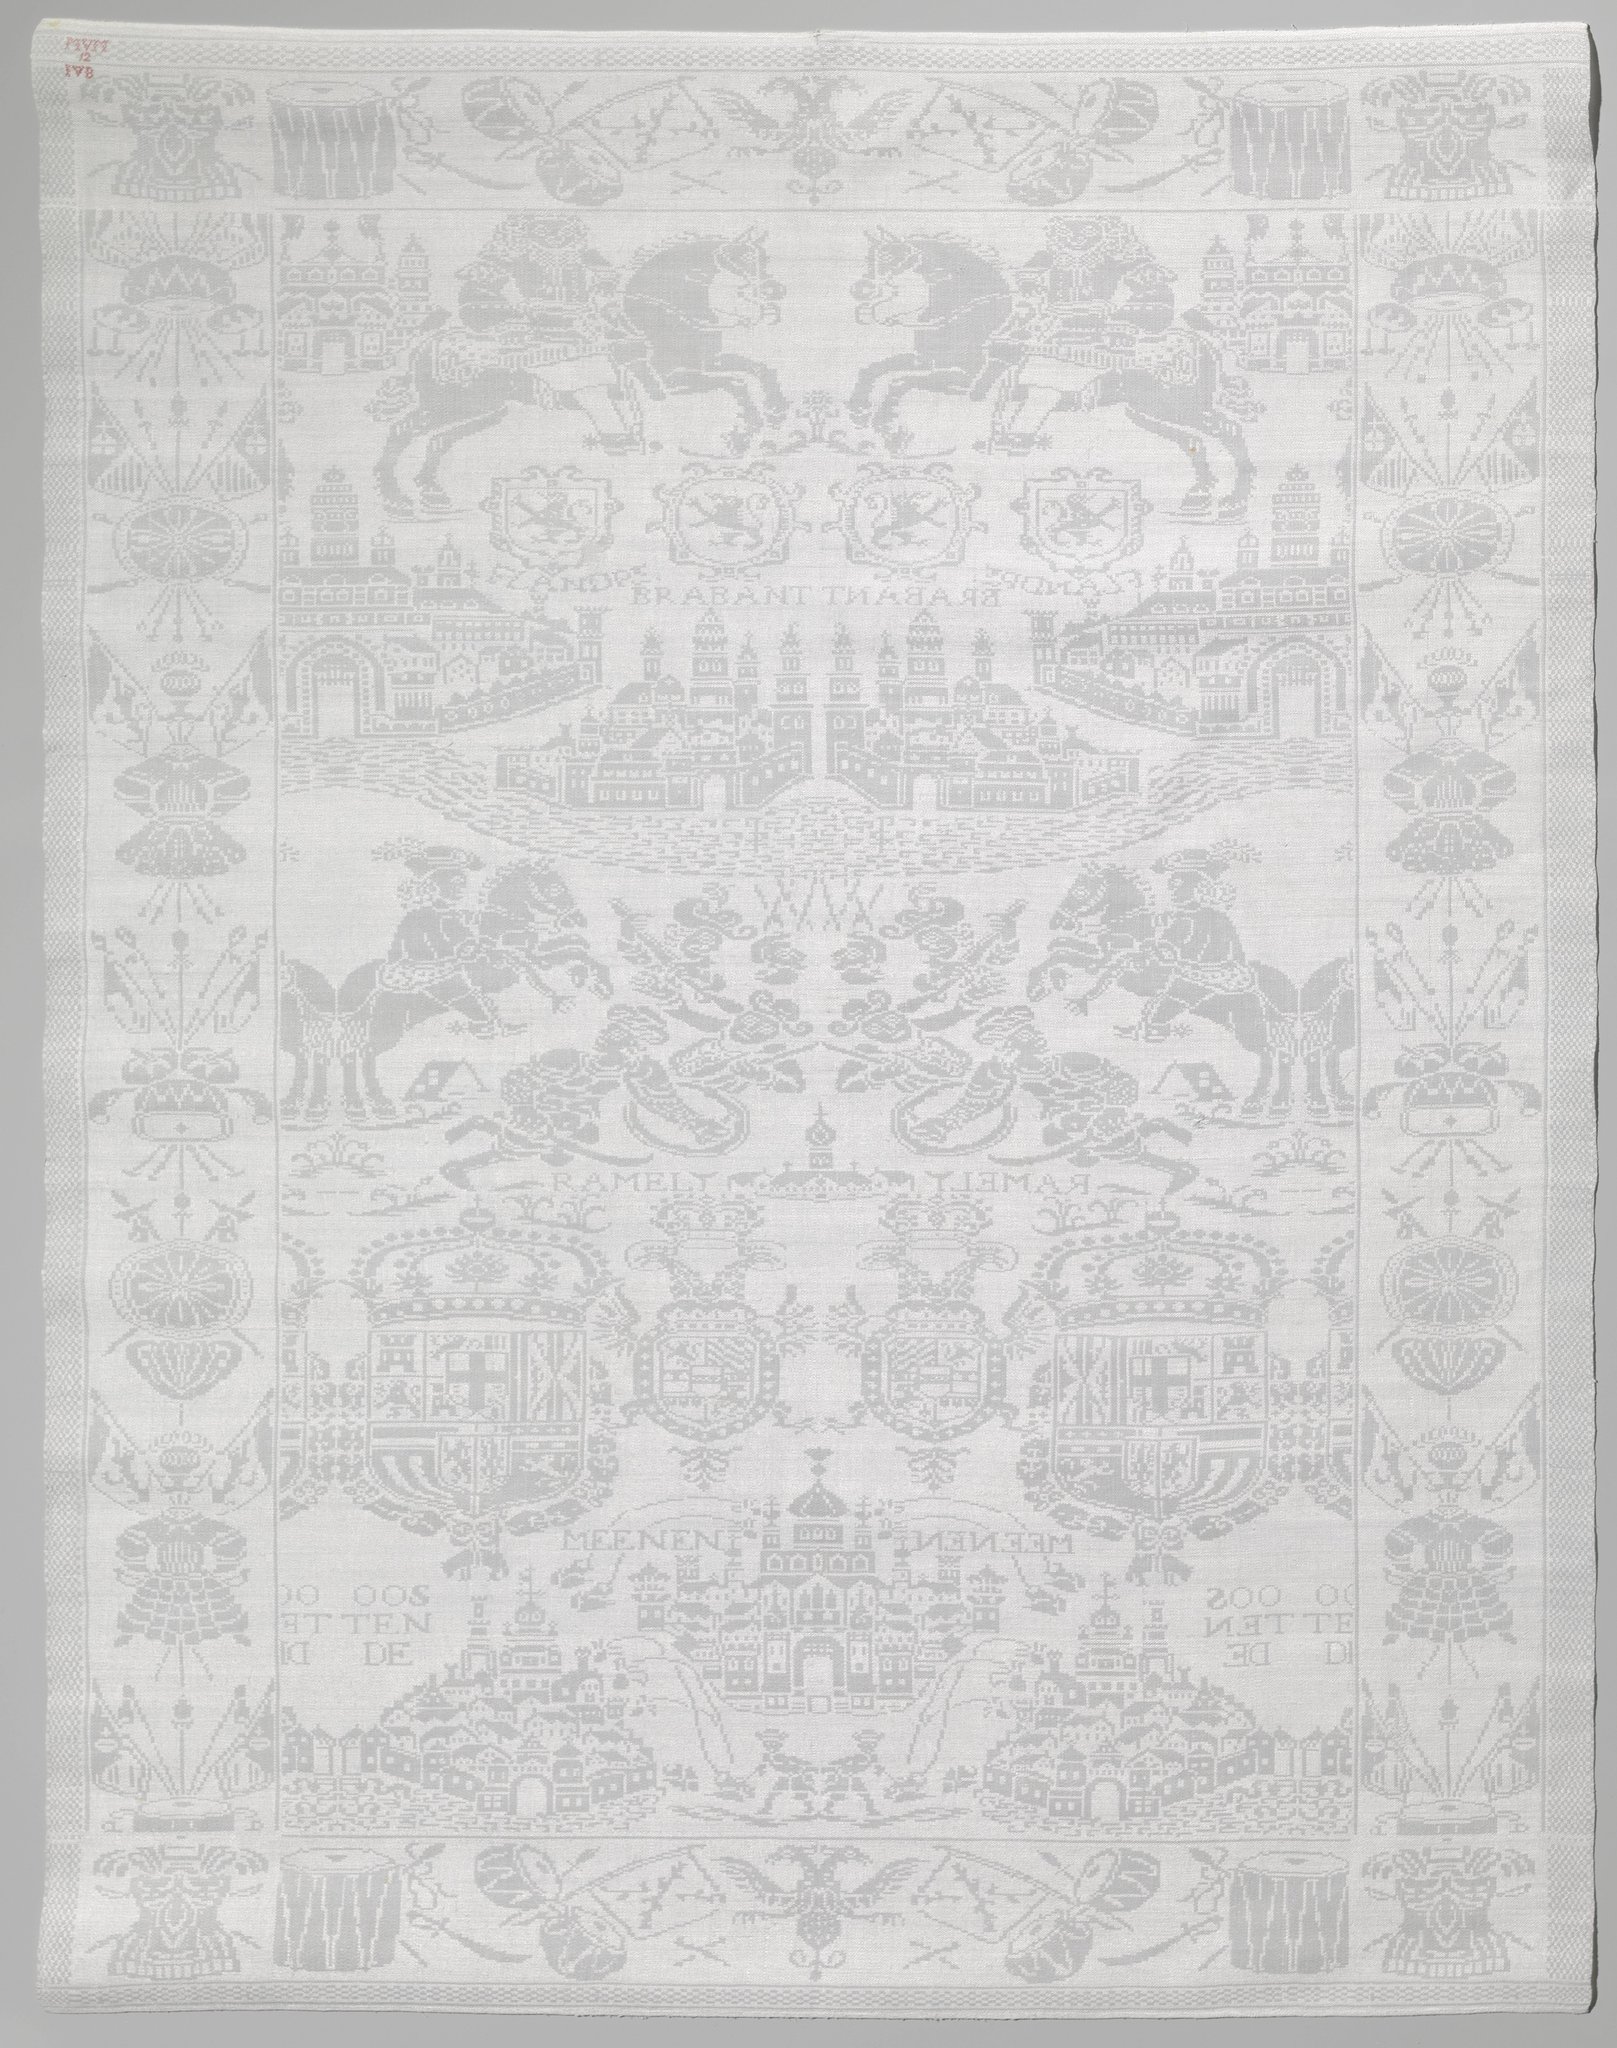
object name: napkin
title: Servet van linnendamast met een historisch tafereel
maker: Anonymous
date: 1706-1725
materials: linen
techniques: damask, weave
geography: flanders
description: Servet van linnendamast met de verheerlijking van Karel III als koning van Spanje na de slag bij Ramilies. Het servet is in rood gemerkt met een kruissteek: MVM 12 FVB en hoort bij een servet met invnr. BK-1977-305-A.